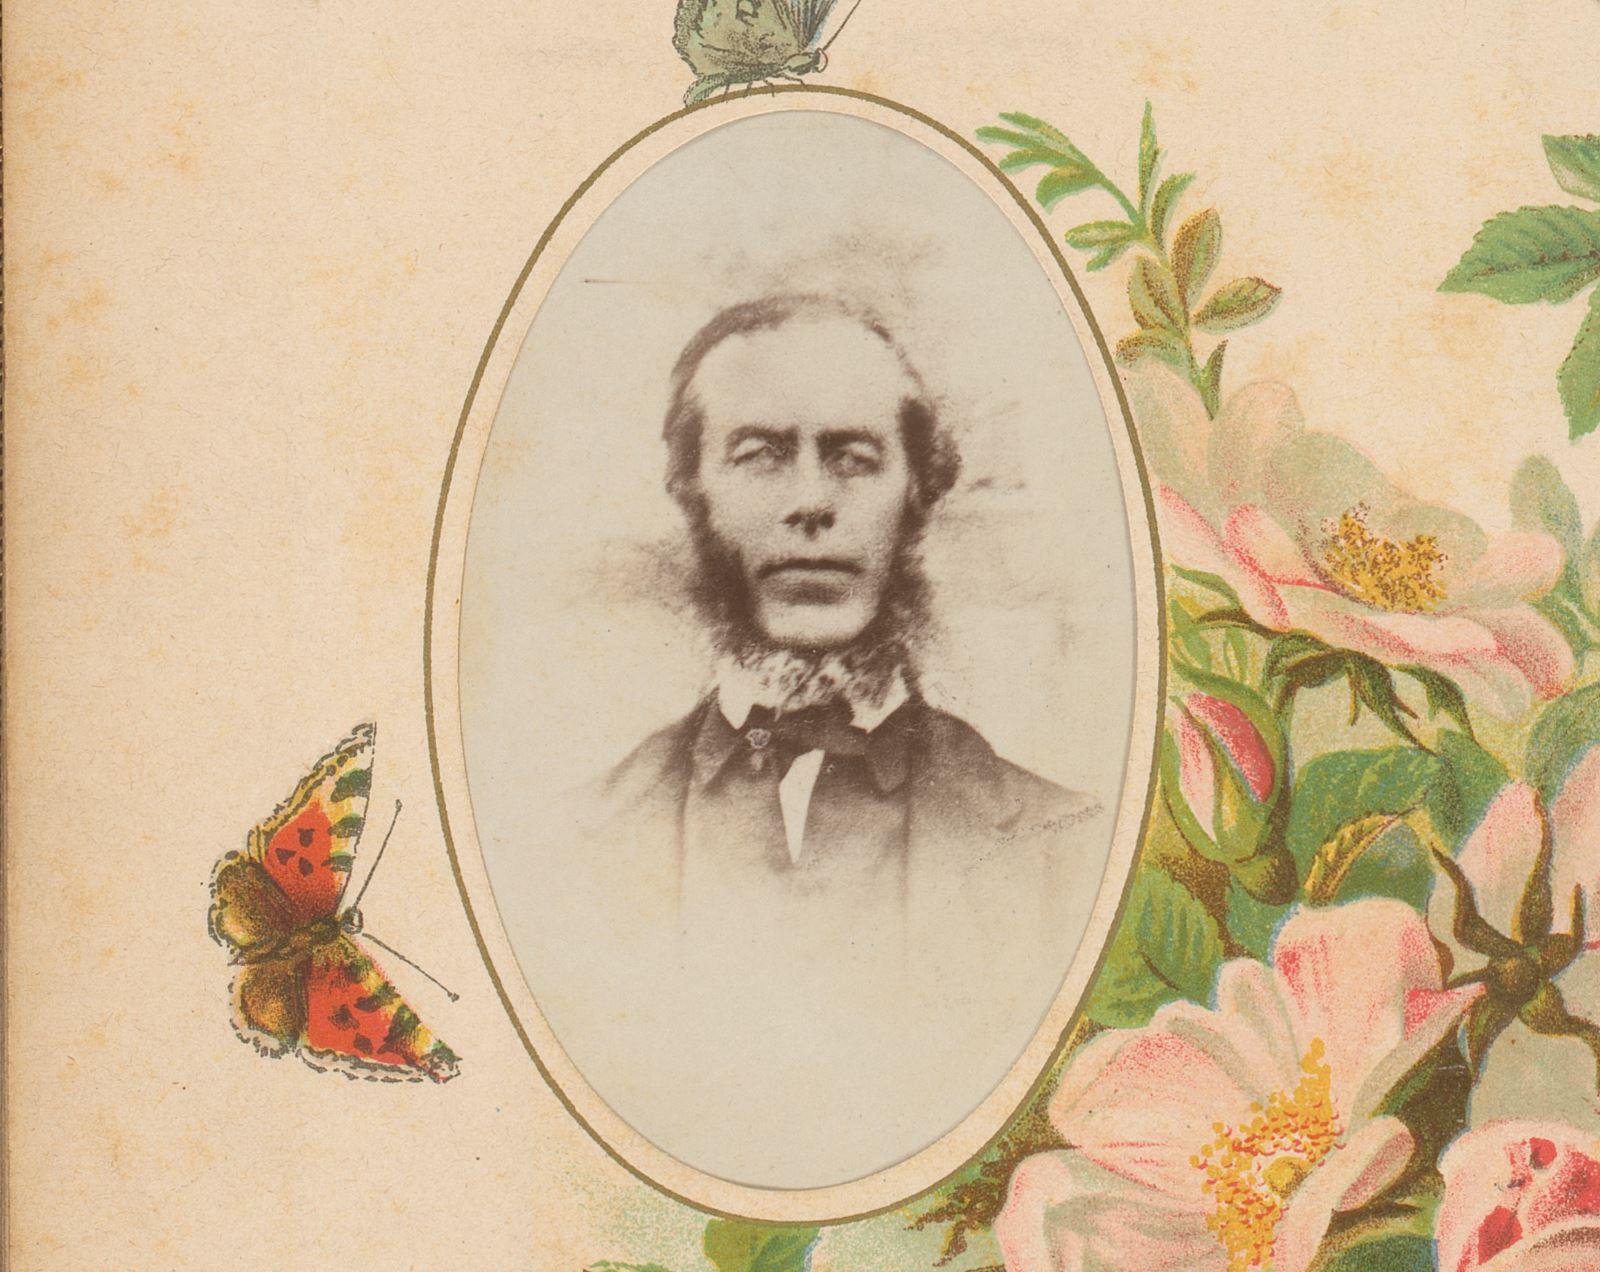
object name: carte de visite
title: Portret van een man met bakkenbaarden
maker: s. knott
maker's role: fotograaf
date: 1860-1900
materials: cardboard, photographic support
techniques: albumen print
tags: sideburns, adult man, historical persons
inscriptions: inscription: ‘S. Knott Oldham’